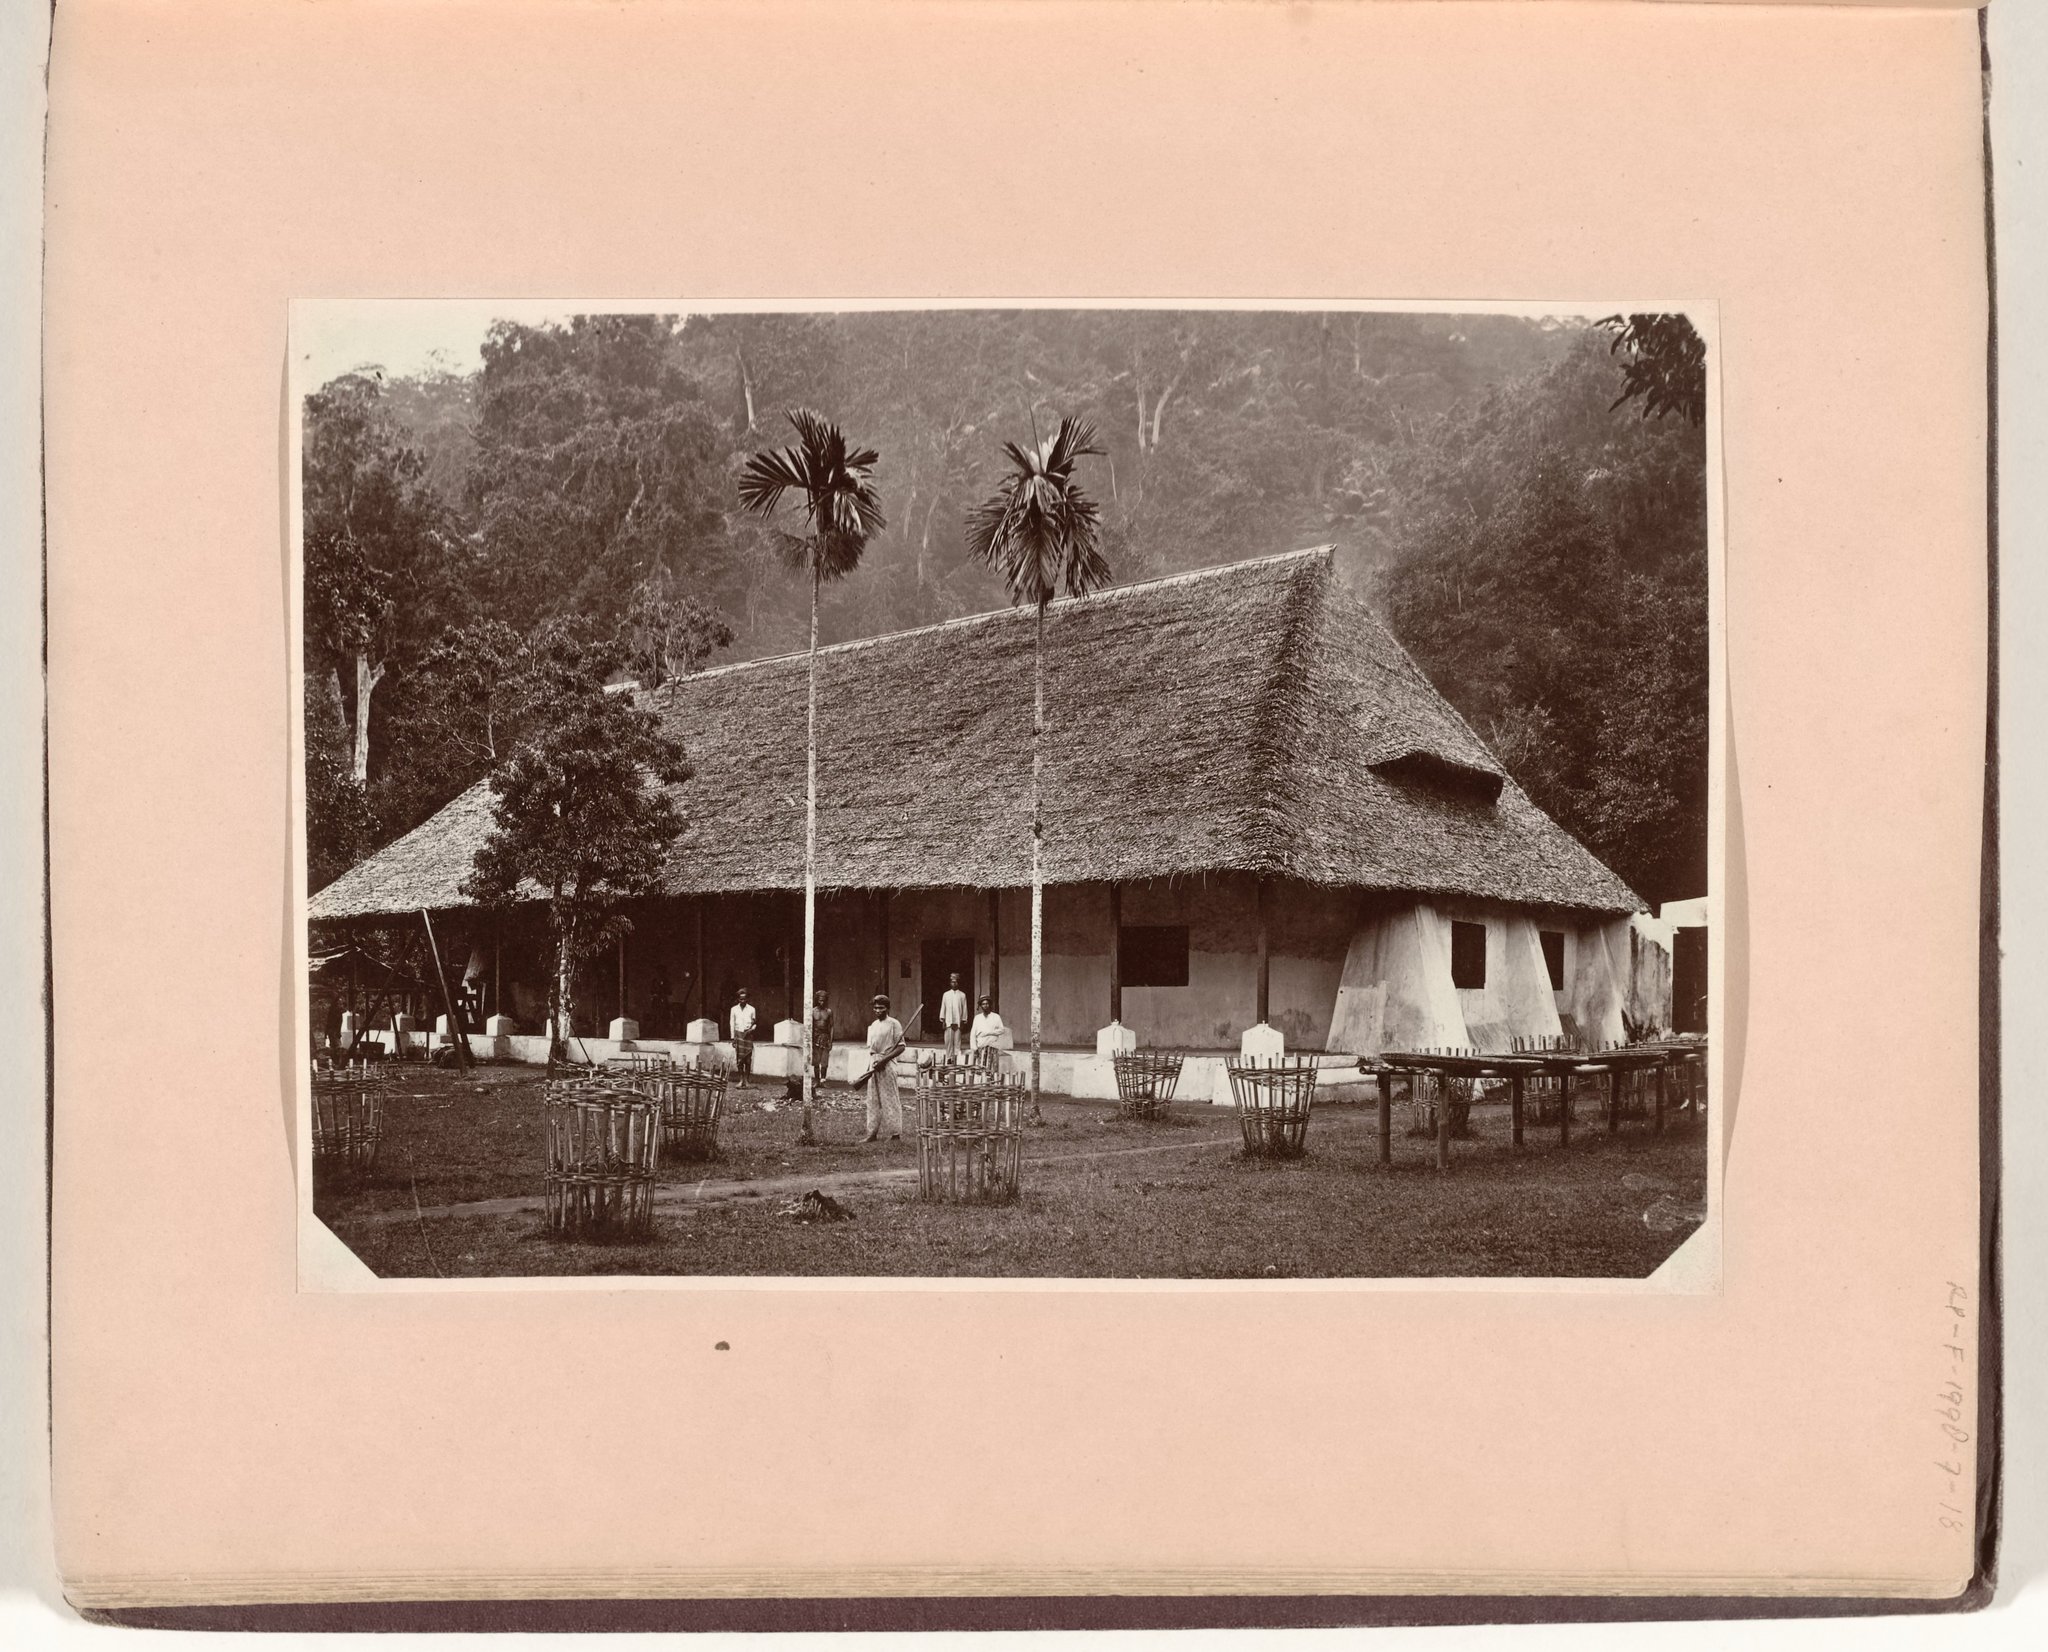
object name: album leaf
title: Gebouw waar nootmuskaat gekookt wordt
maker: c. dietrich (fotograaf)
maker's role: fotograaf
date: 1875-1890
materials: cardboard, paper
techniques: albumen print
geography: indonesia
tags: factory-building, fruits: nuts, indonesia